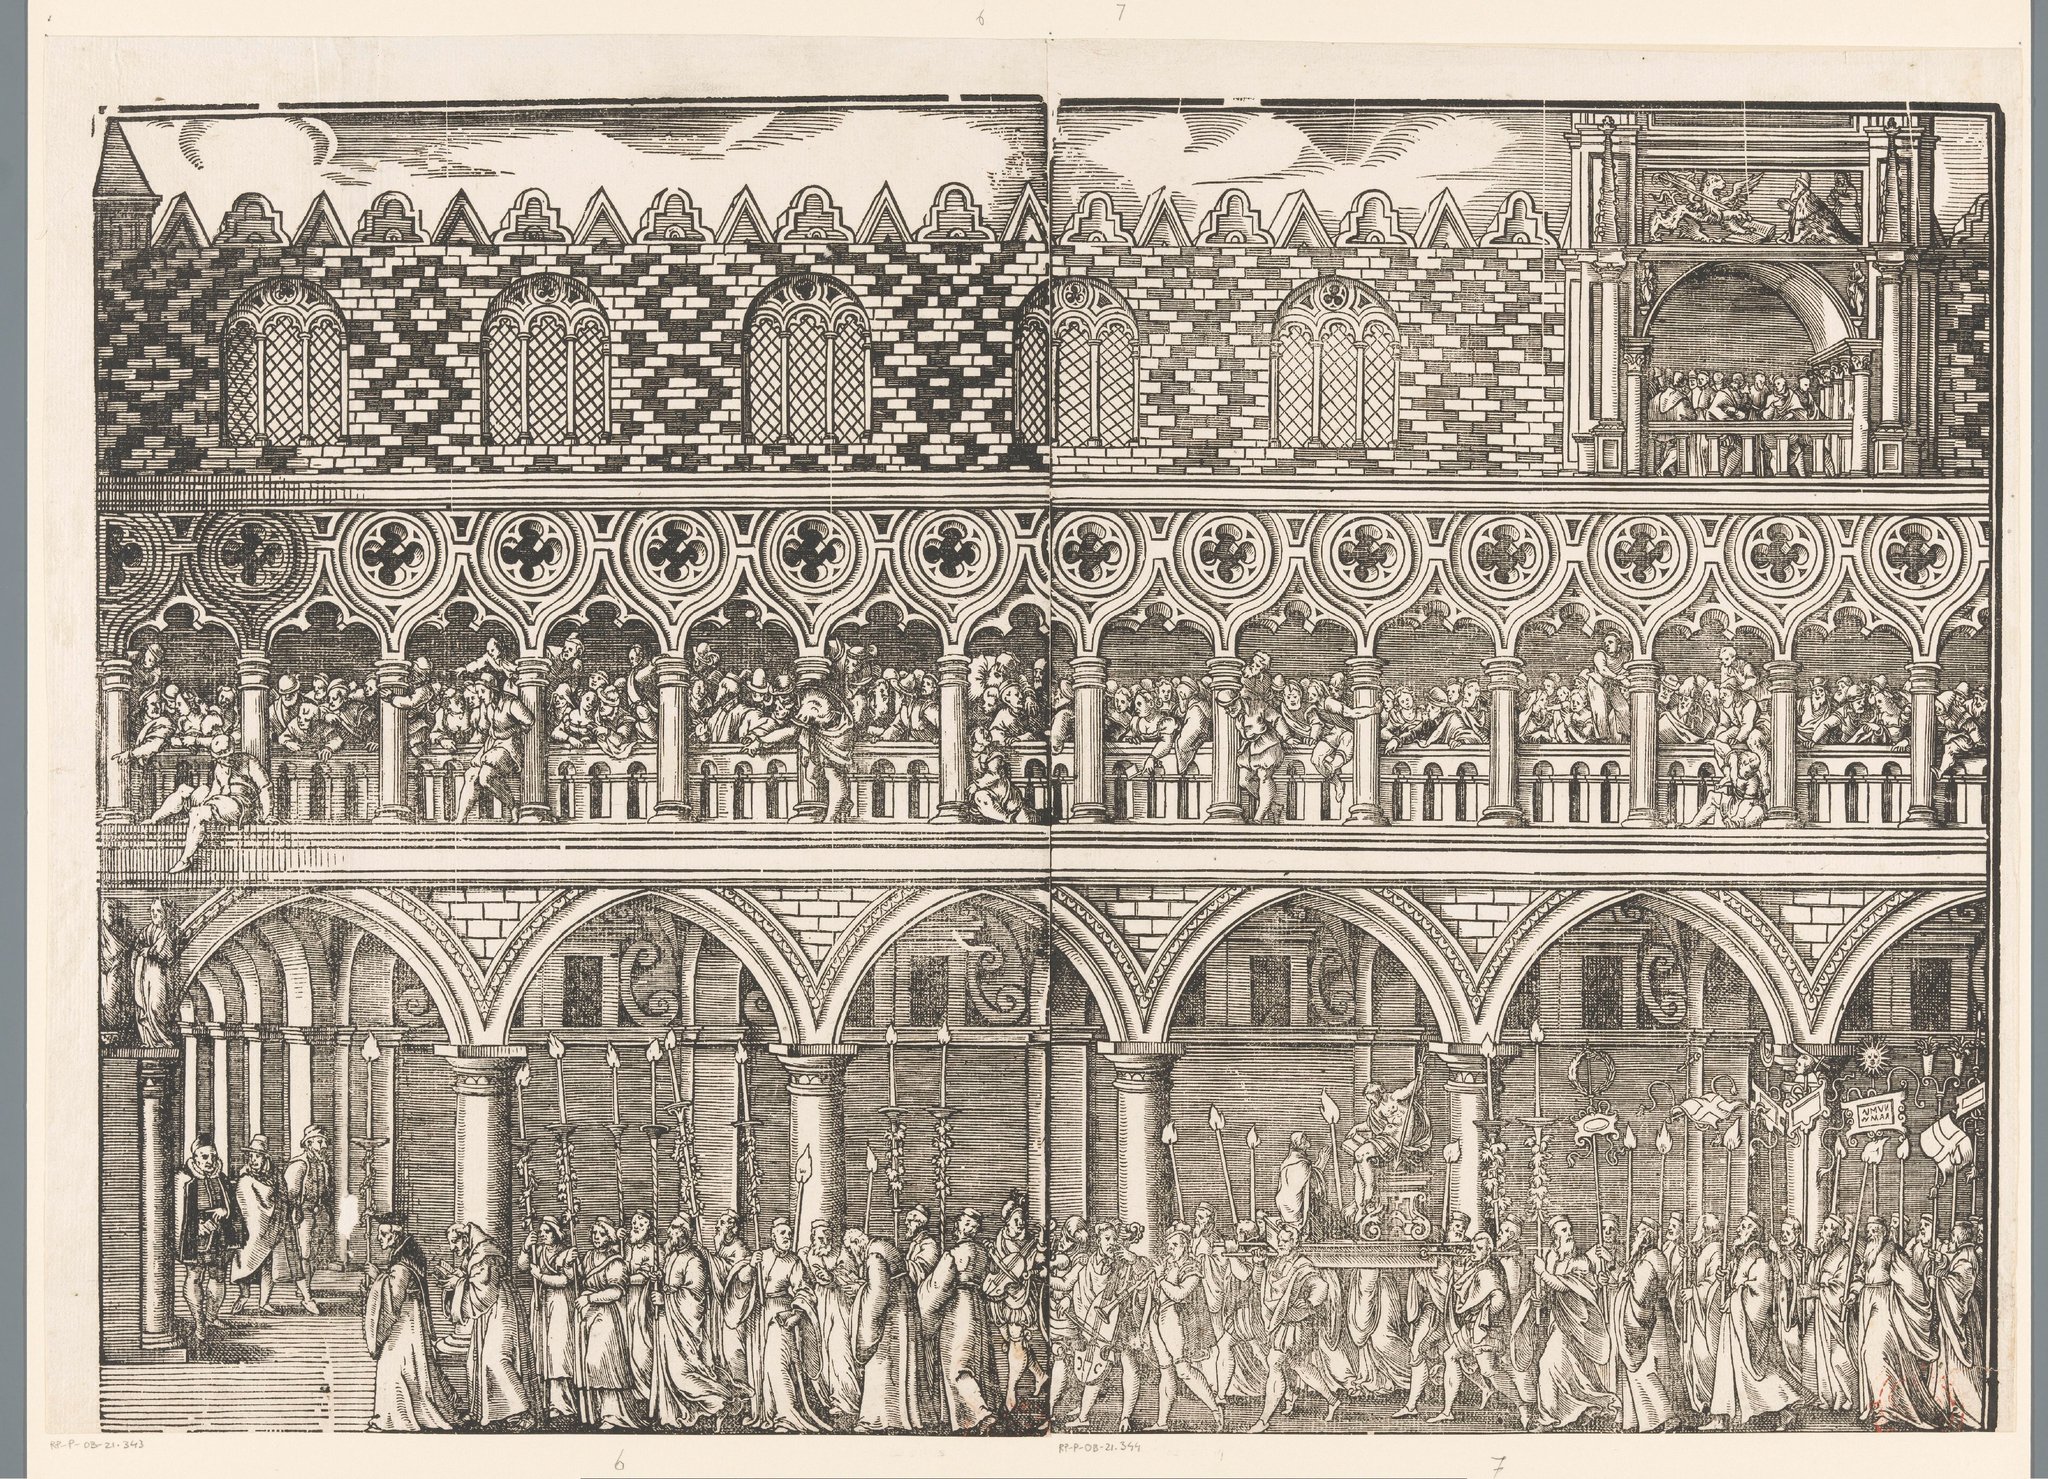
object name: print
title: Festa della Sensa (zesde gedeelte)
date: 1679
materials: paper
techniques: woodcut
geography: nuremberg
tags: city-view in general; 'veduta', string instruments (bowed) - cc - out of doors, procession ~ christian religion, gondola, venice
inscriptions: collector's mark: Lugt 240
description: Zesde gedeelte van een grote voorstelling van de Festa della Sensa. De voorstelling is gedrukt van veertien blokken, de titel van vijf blokken en het onderschrift bestaat uit vijf delen van elk drie kolommen Duits tekst. De veertien blokken die samen de voorstelling vormen zijn in de titels met de klok mee vanaf linksboven genummerd. In de collectie Rijksmuseum bevinden zich twee complete exemplaren inclusief titel en onderschrift. Omdat niet alle delen van de titel en het onderschrift op afzonderlijke bladen zijn gedrukt, is dit exemplaar niet virtueel samengevoegd omwille van een betere presentatie. Zie voor het andere exemplaar: RP-P-2017-6073.